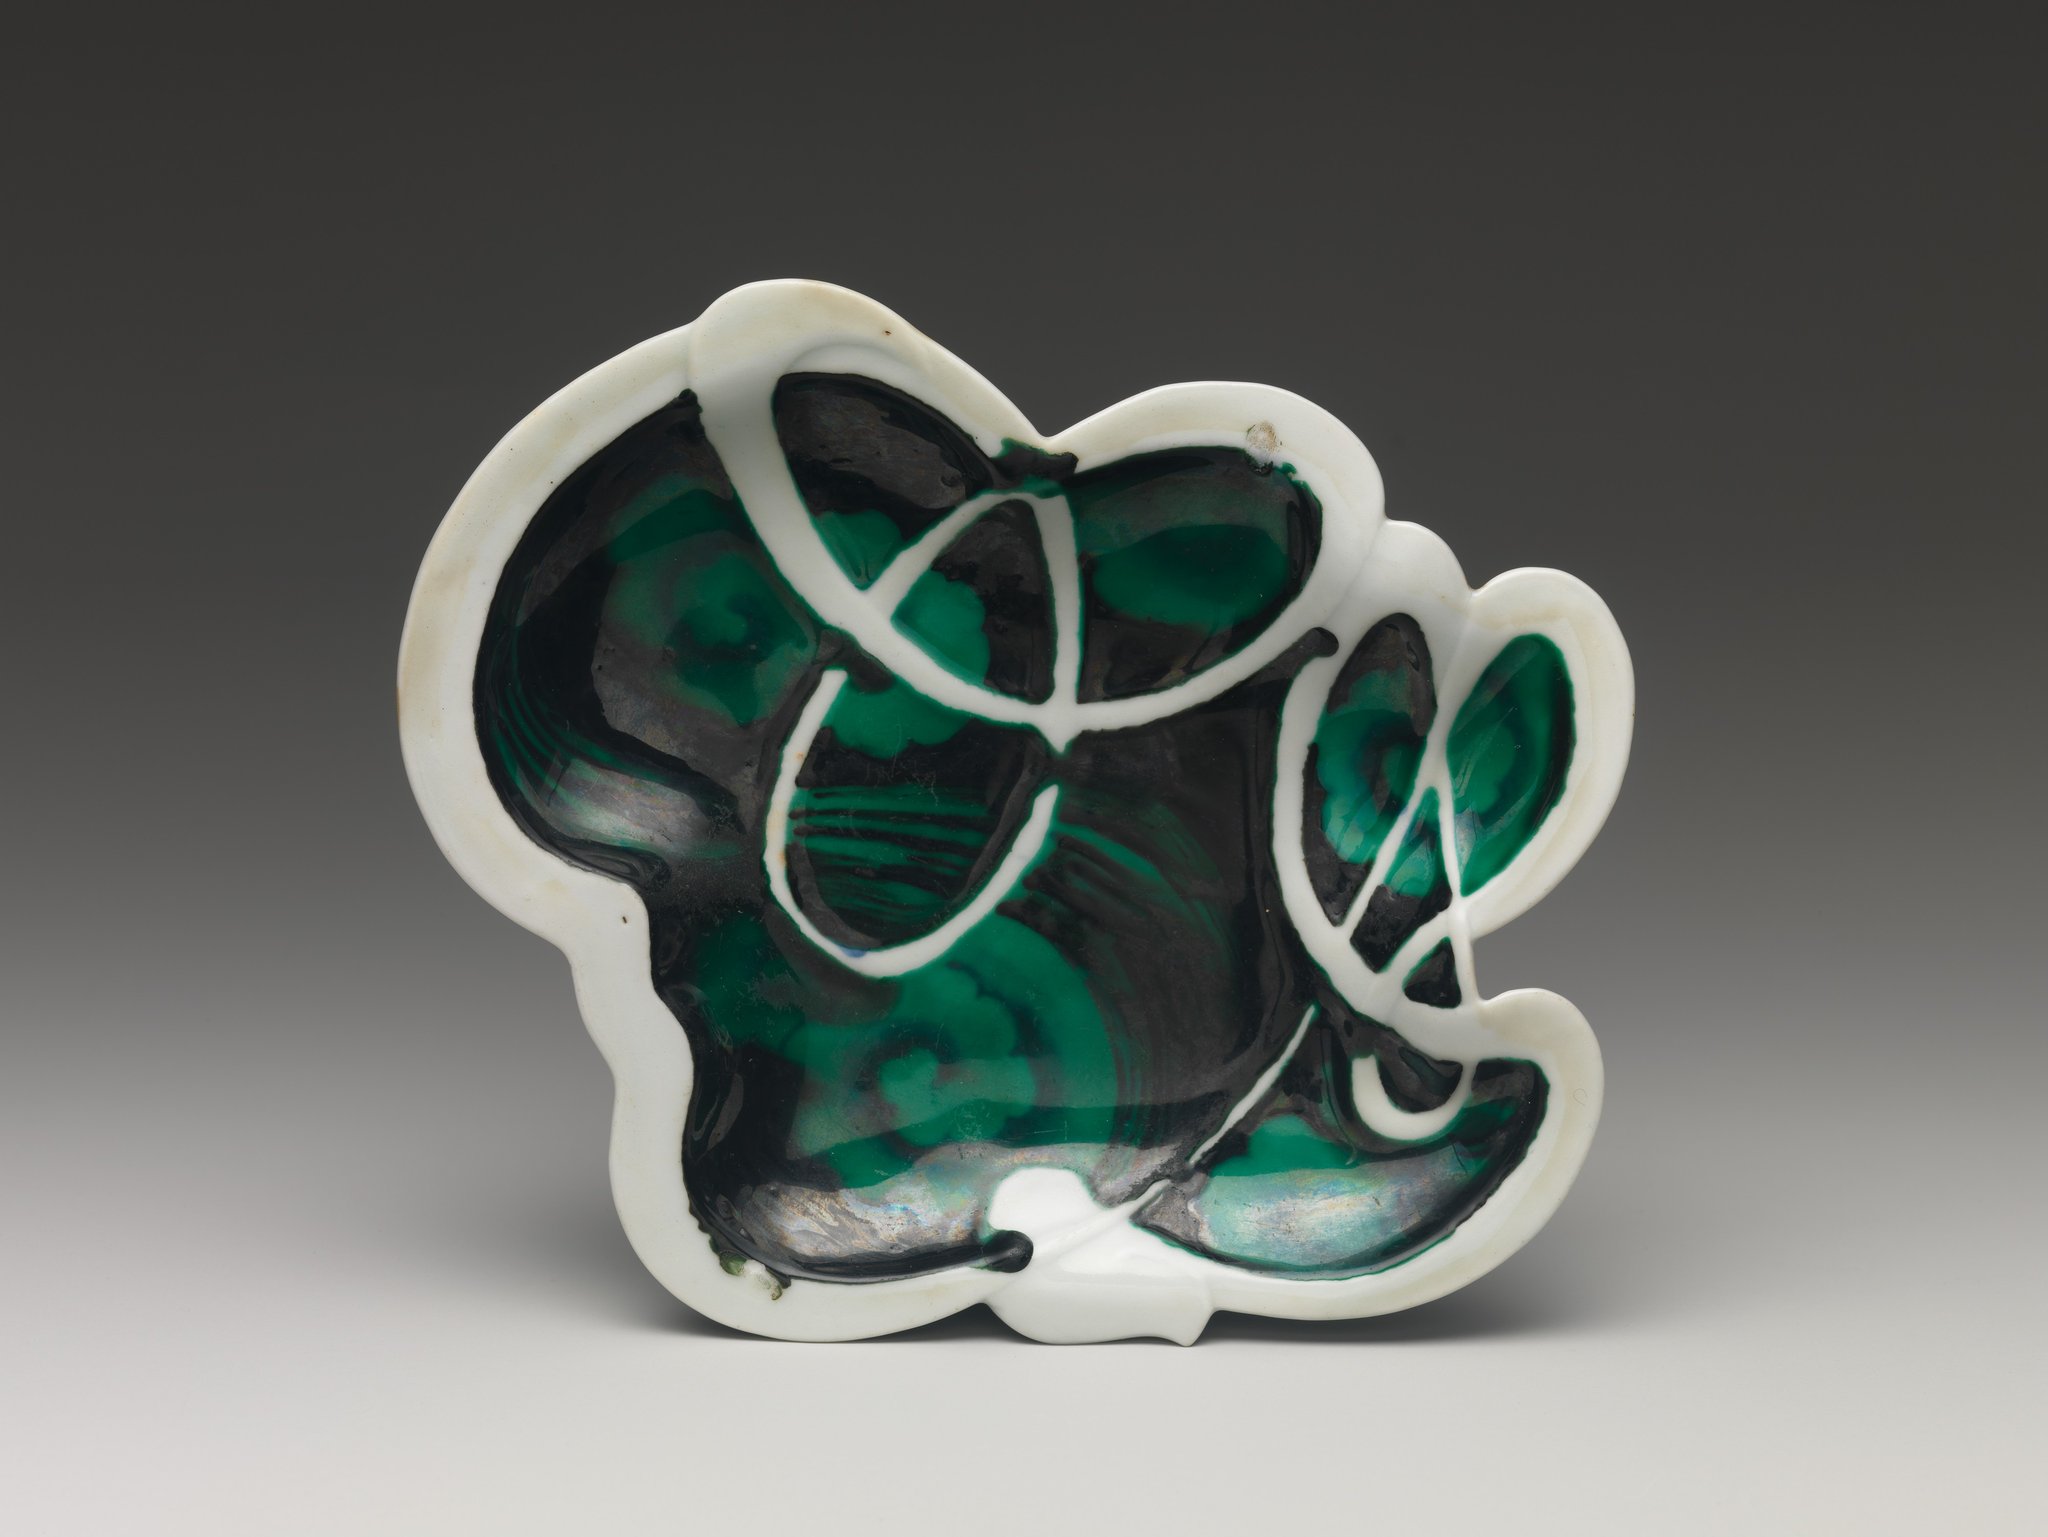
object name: dish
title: Dish with Abstract Design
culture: japanese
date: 1651-1700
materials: enamel, porcelain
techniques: overglaze, polychrome